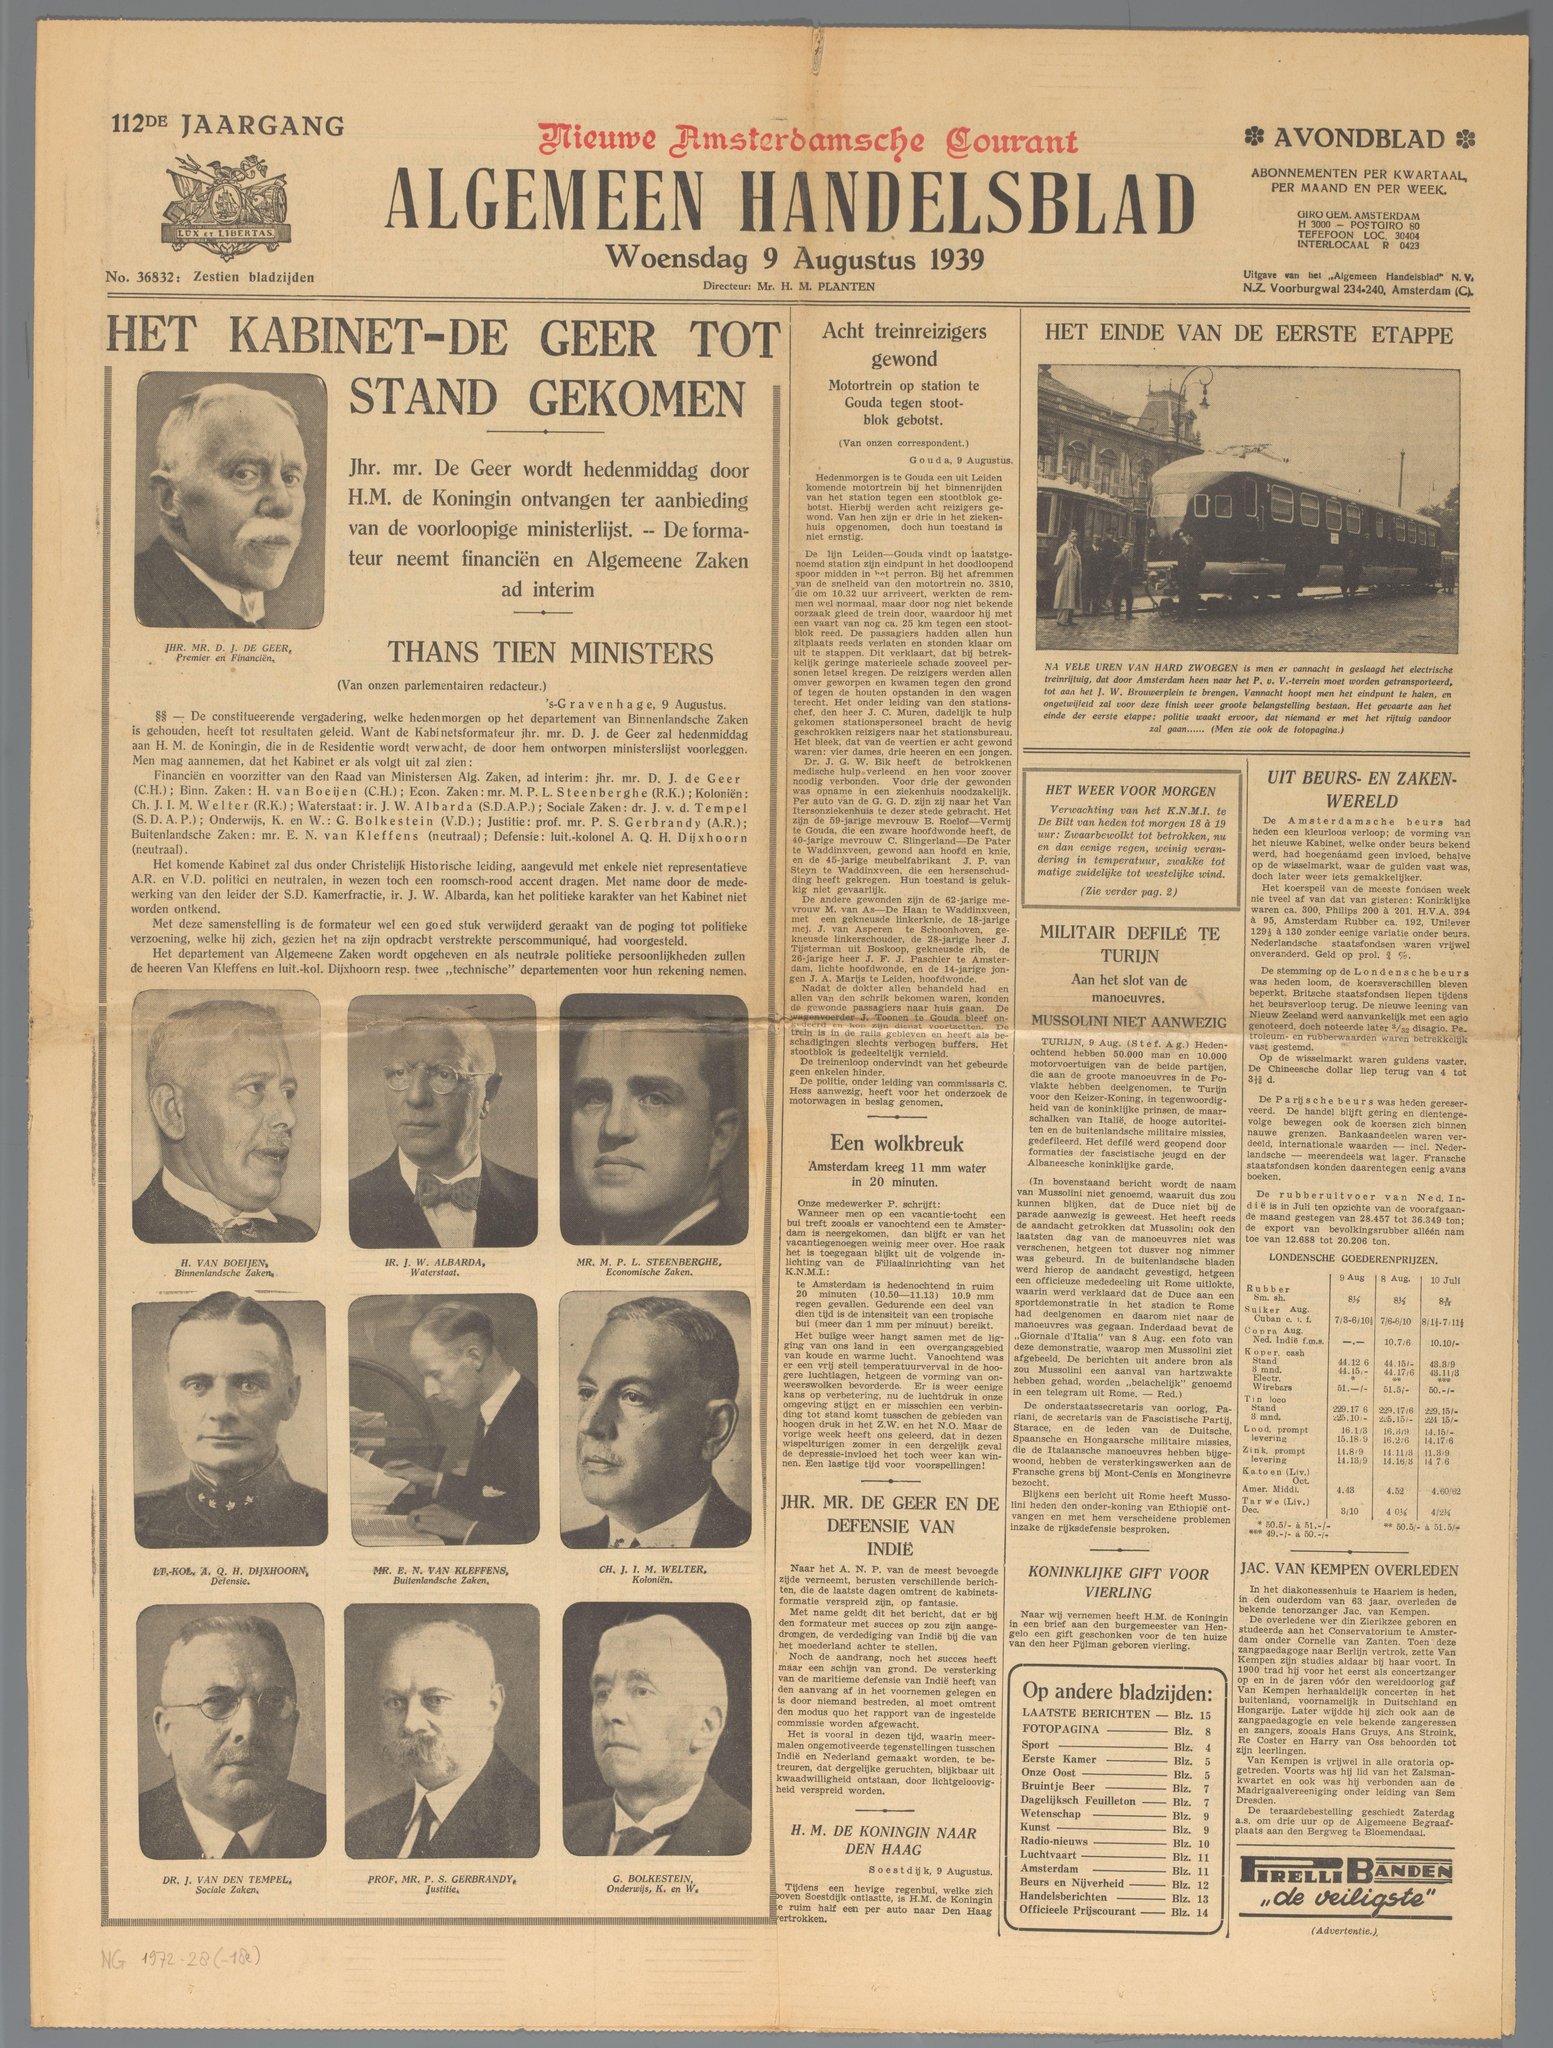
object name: newspaper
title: Algemeen Handelsblad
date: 1939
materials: paper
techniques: printing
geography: amsterdam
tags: newspaper, politician, netherlands